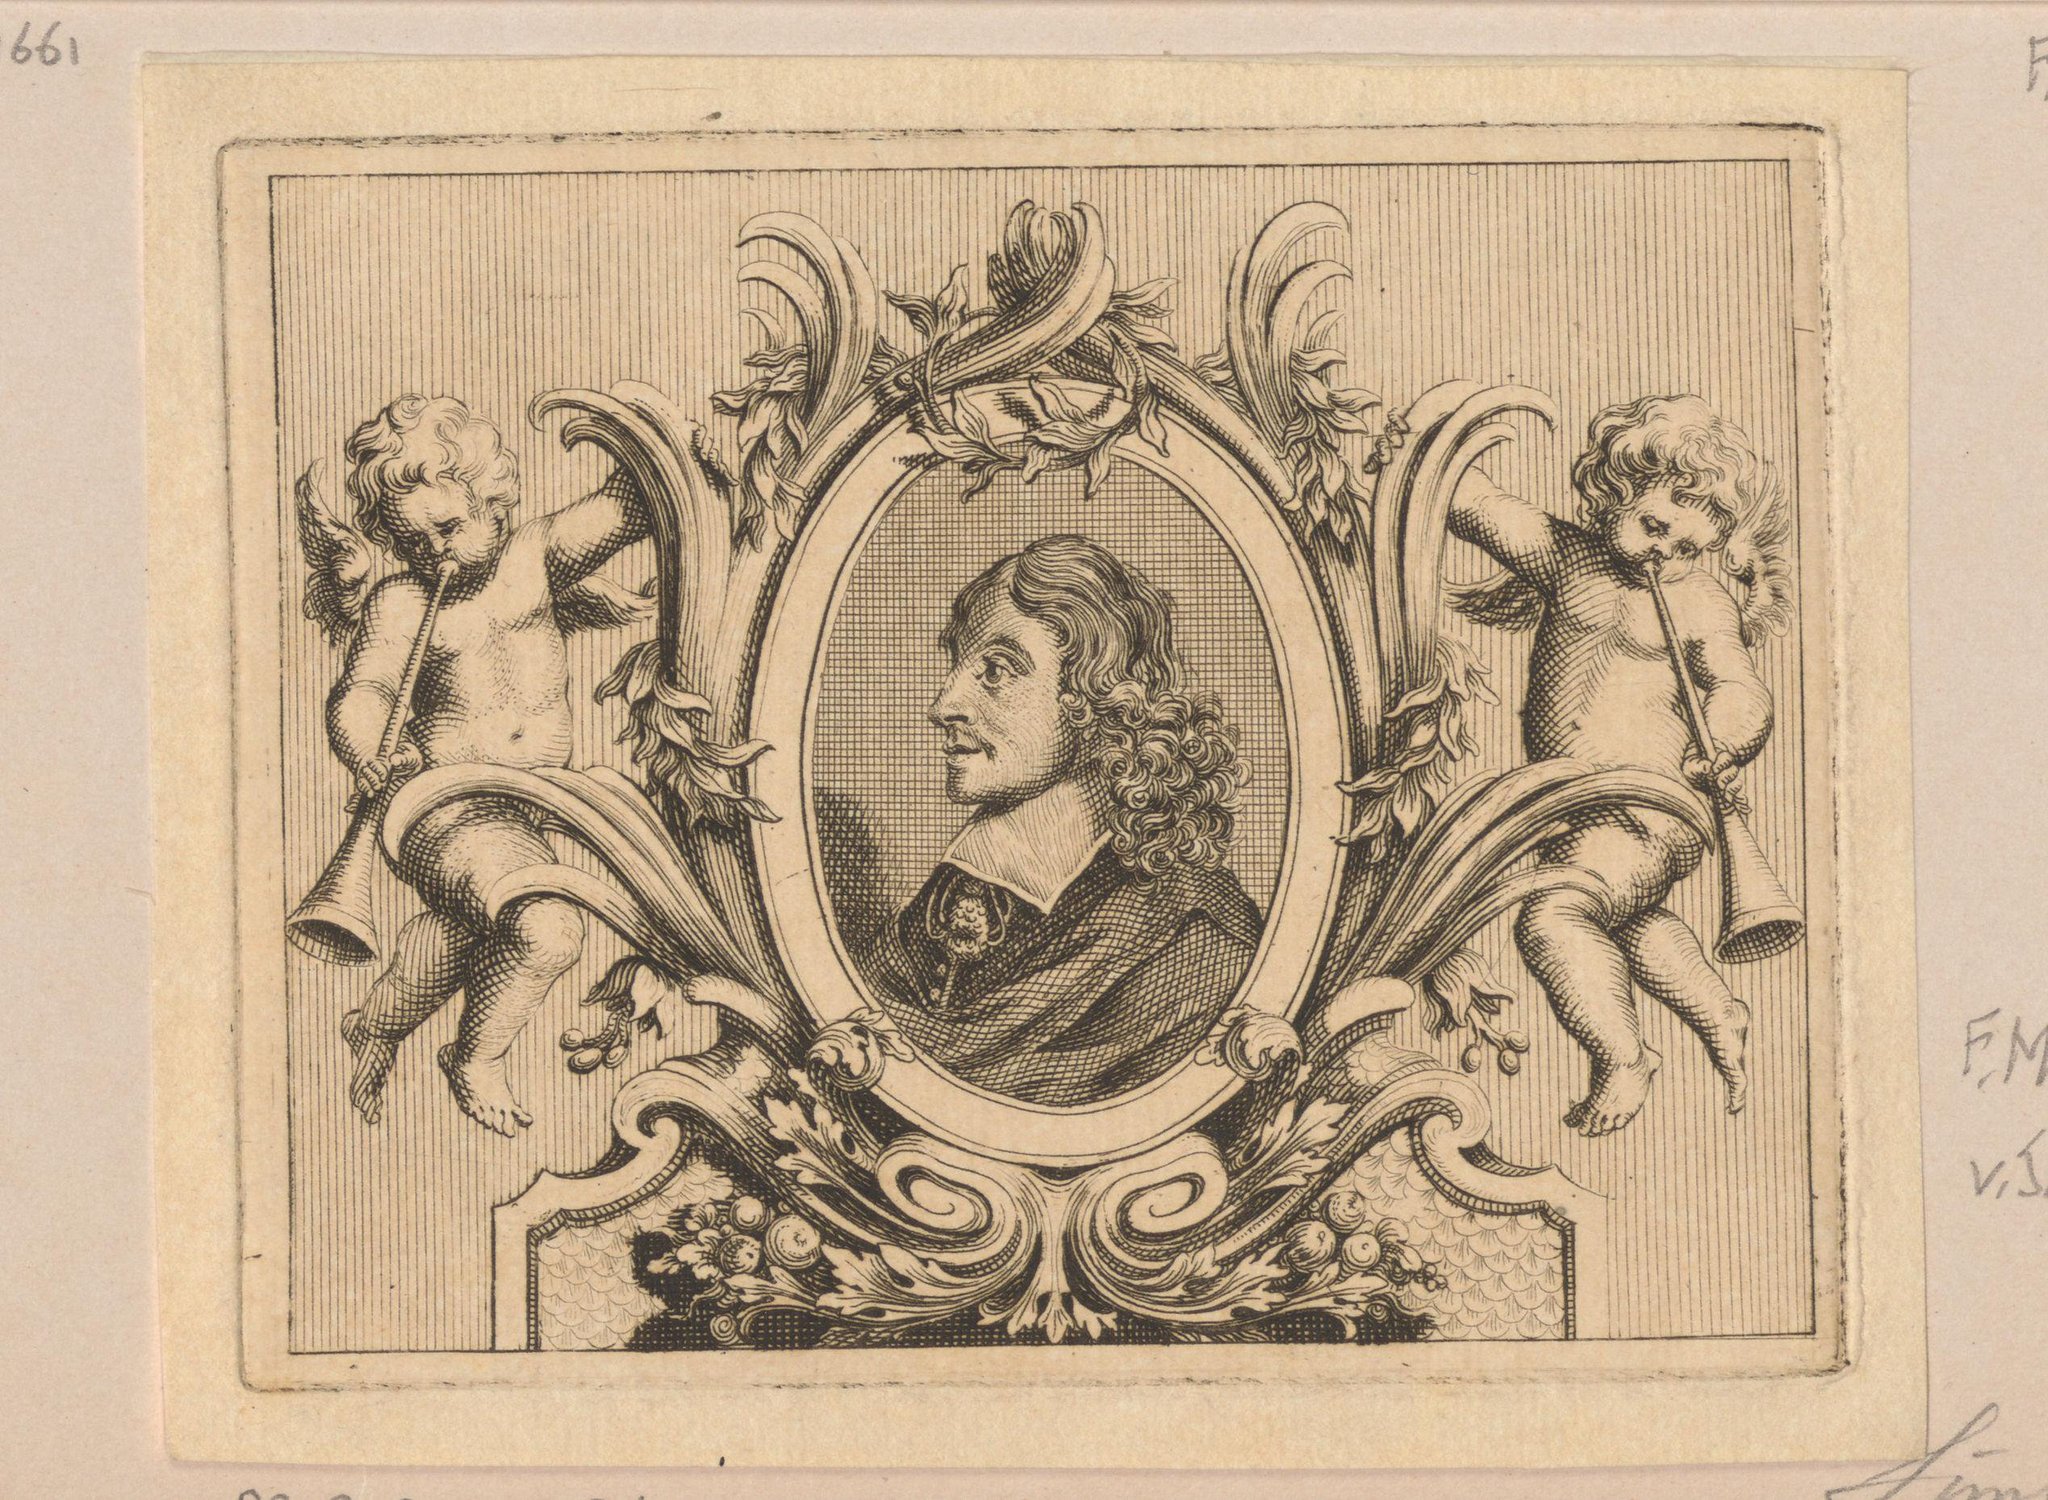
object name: print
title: Portret van Simon van Leeuwen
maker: Anonymous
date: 1701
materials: paper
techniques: engraving, etching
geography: northern netherlands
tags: leiden, the hague, simon van leeuwen, horn, trumpet, cornet, trombone, tuba, ornament ~ medallion, historical persons, lawyer, attorney at law, cupids: 'amores', 'amoretti', 'putti'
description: Prent met tekst in boekdruk op verso gebruikt in: Pars, Adriaan. Index Batavicus of Naamrol van de Batavise en Hollandse schrijvers (...). Leiden: Abraham de Swart, 1701.